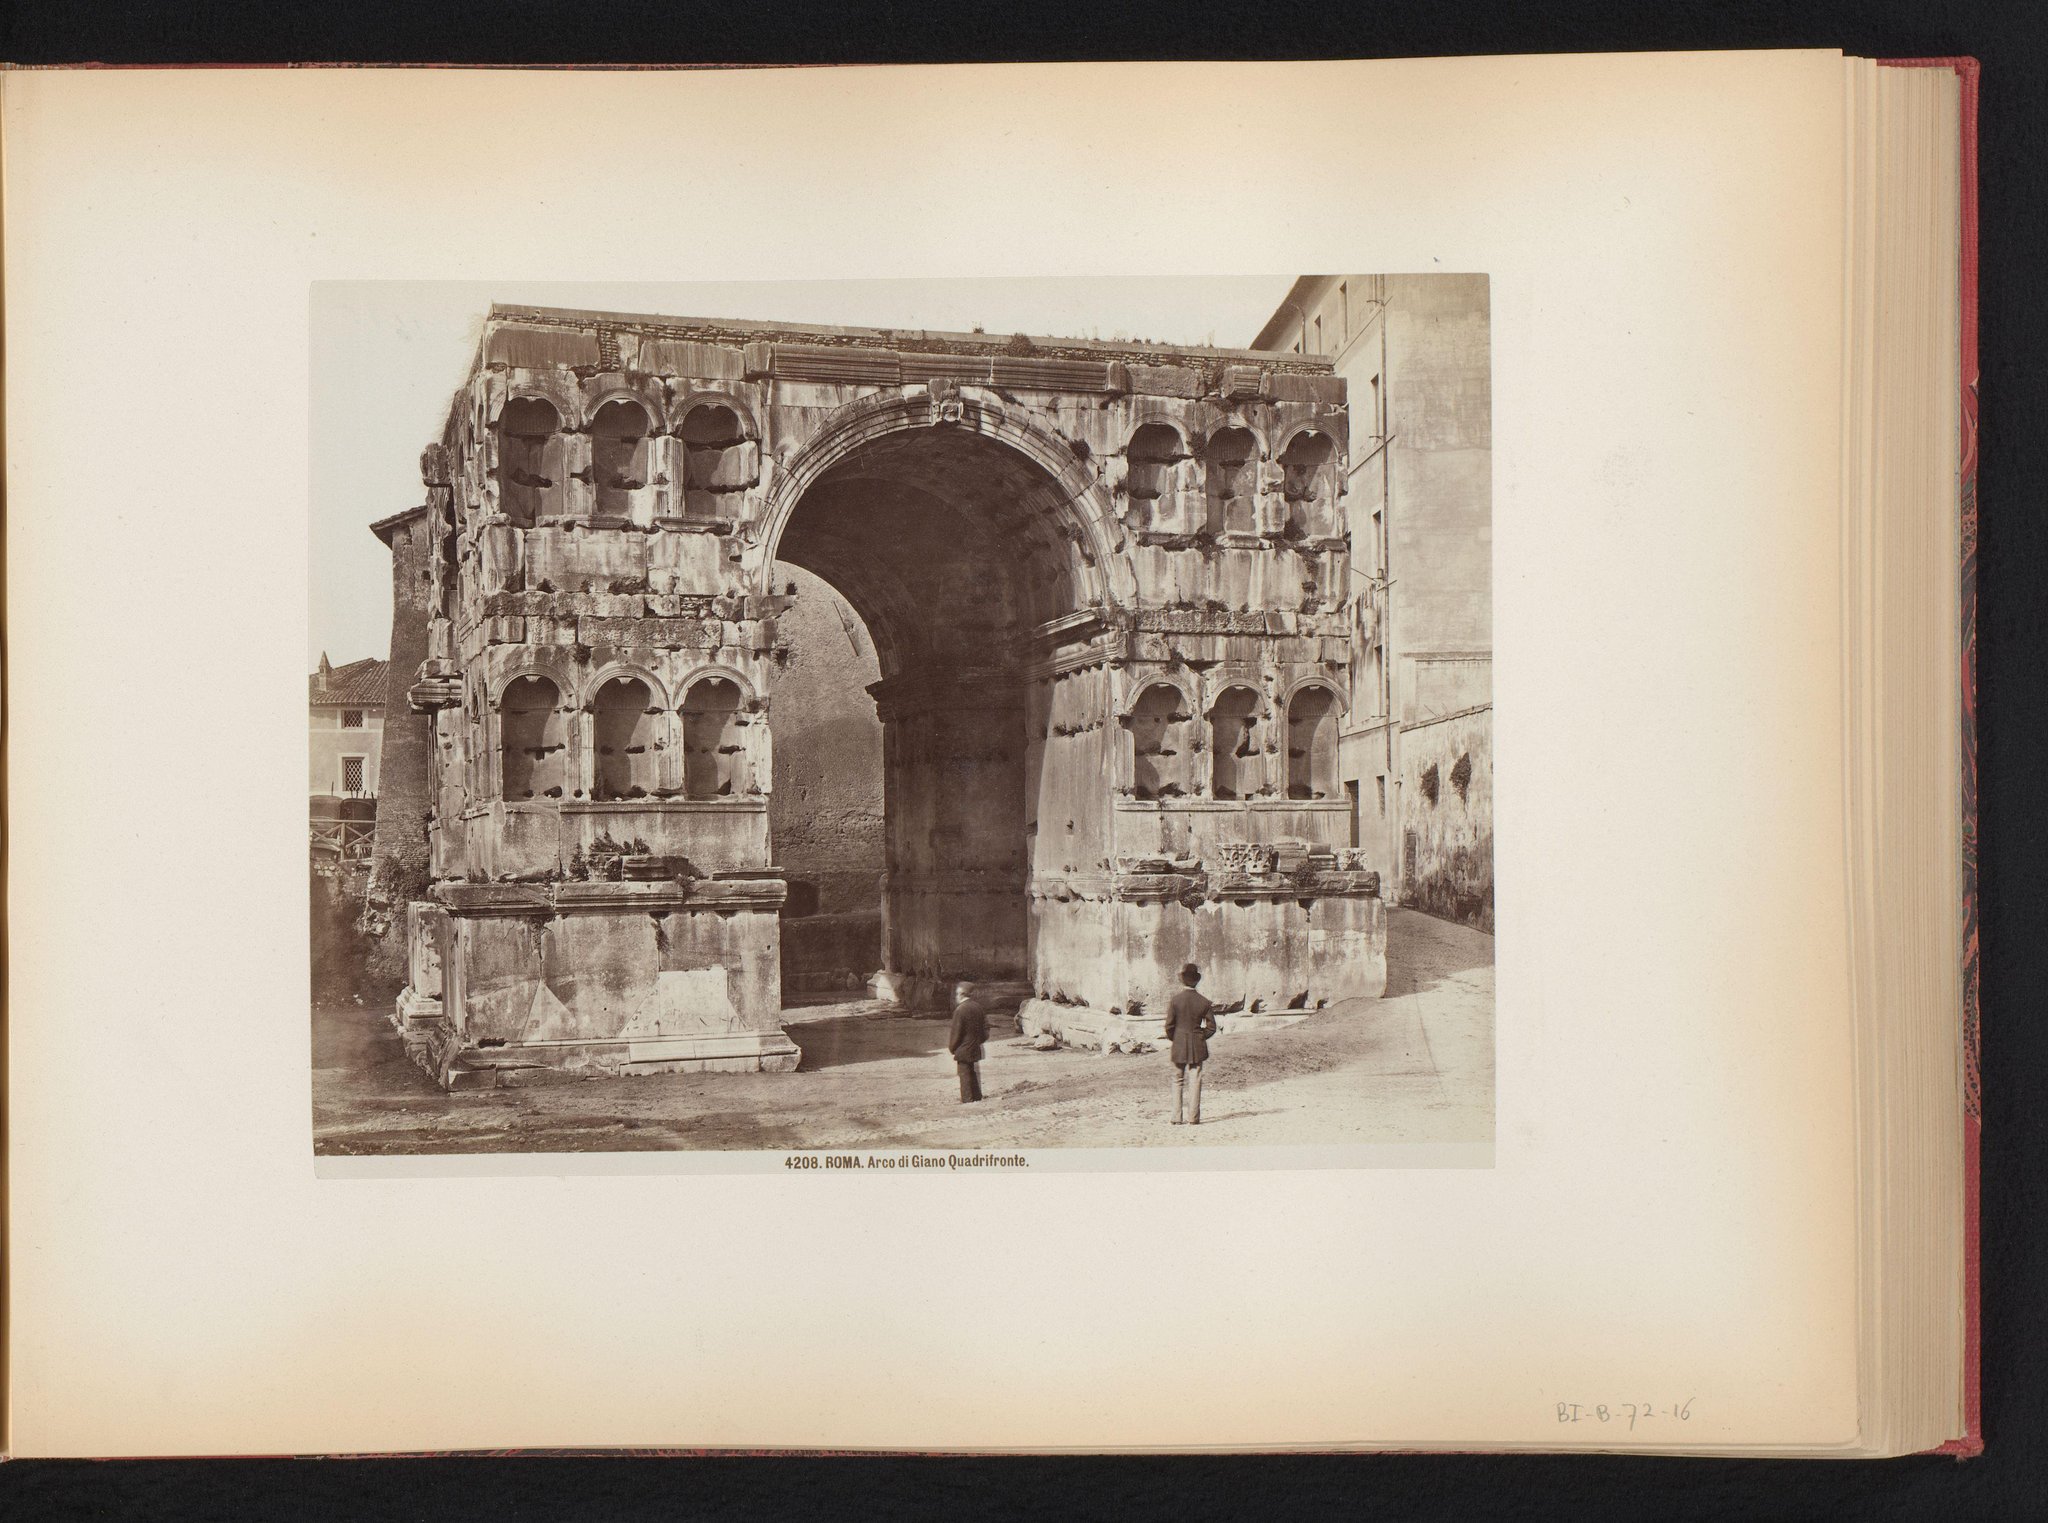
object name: album leaf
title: Boog van Janus te Rome, Italië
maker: giacomo brogi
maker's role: fotograaf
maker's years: 1822-1881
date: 1870-1881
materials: paper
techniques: albumen print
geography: rome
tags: ruin of a building ~ architecture, gate, entrance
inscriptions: number: ‘4208.’